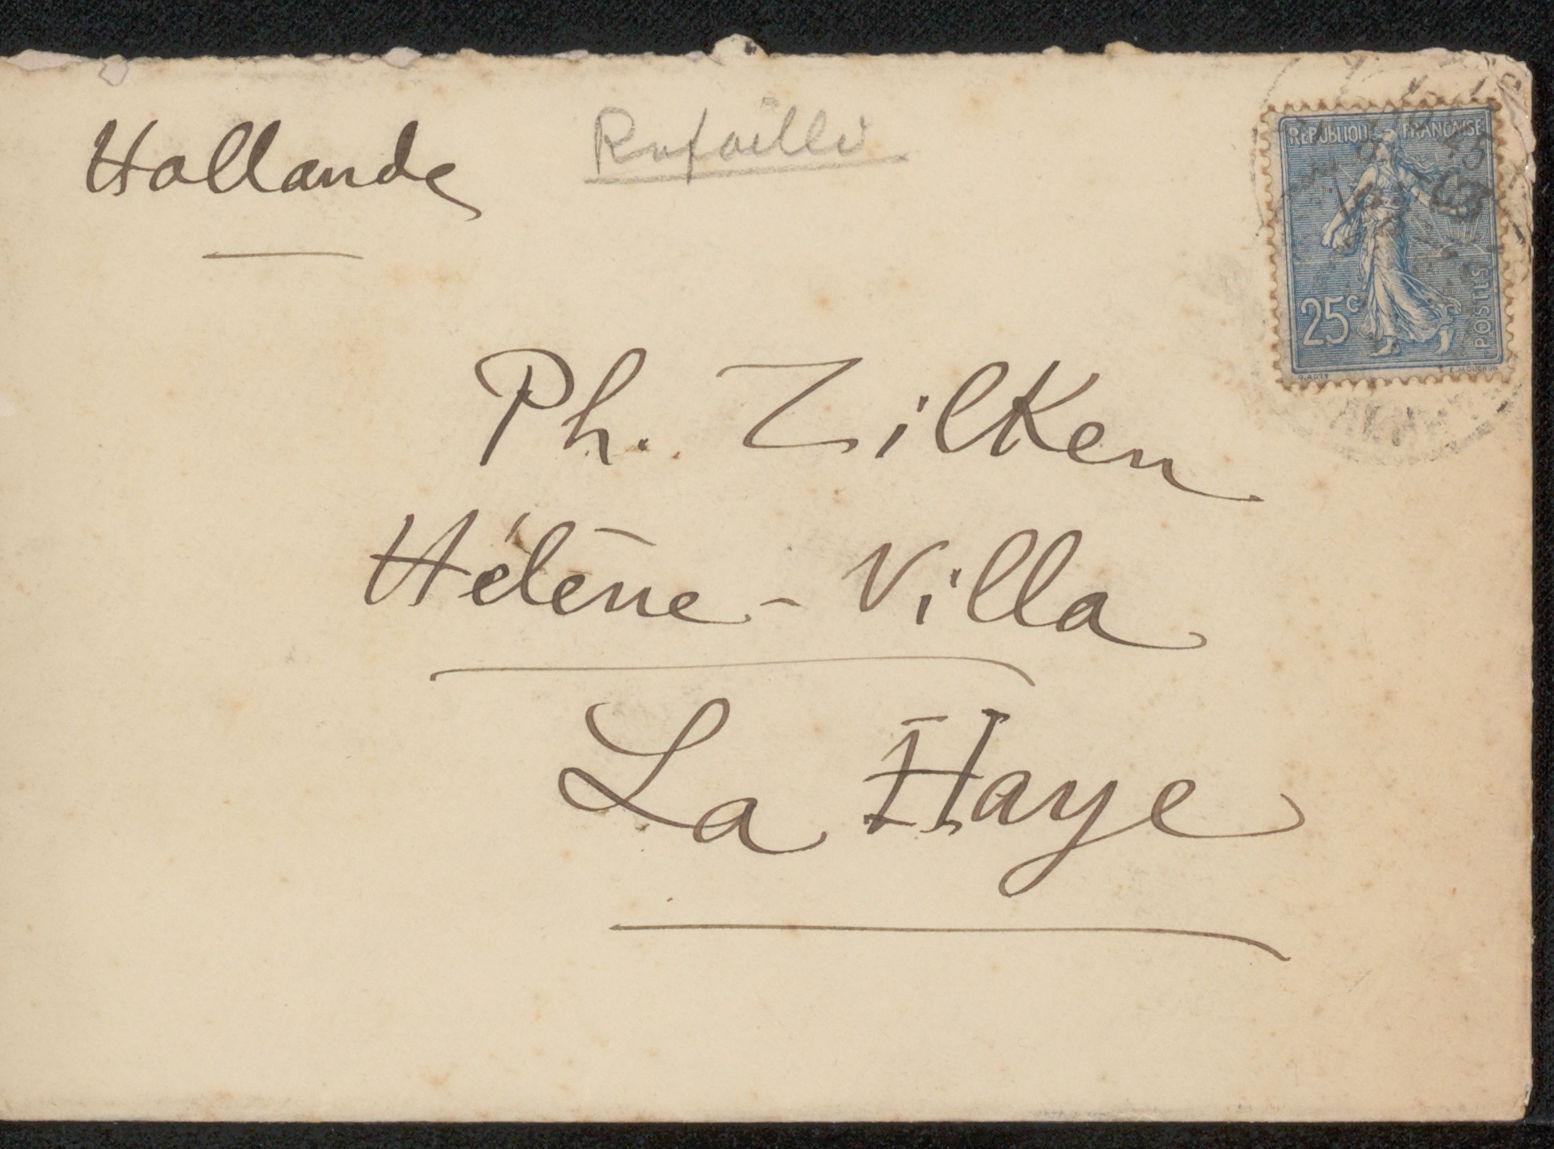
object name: envelope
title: Envelop aan Philip Zilcken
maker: jean françois raffaëlli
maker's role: print maker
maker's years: 1850-1924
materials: ink, paper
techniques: pen, writing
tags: the hague, painter, draughtsman, philip zilcken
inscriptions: collector's mark: ‘RPK’